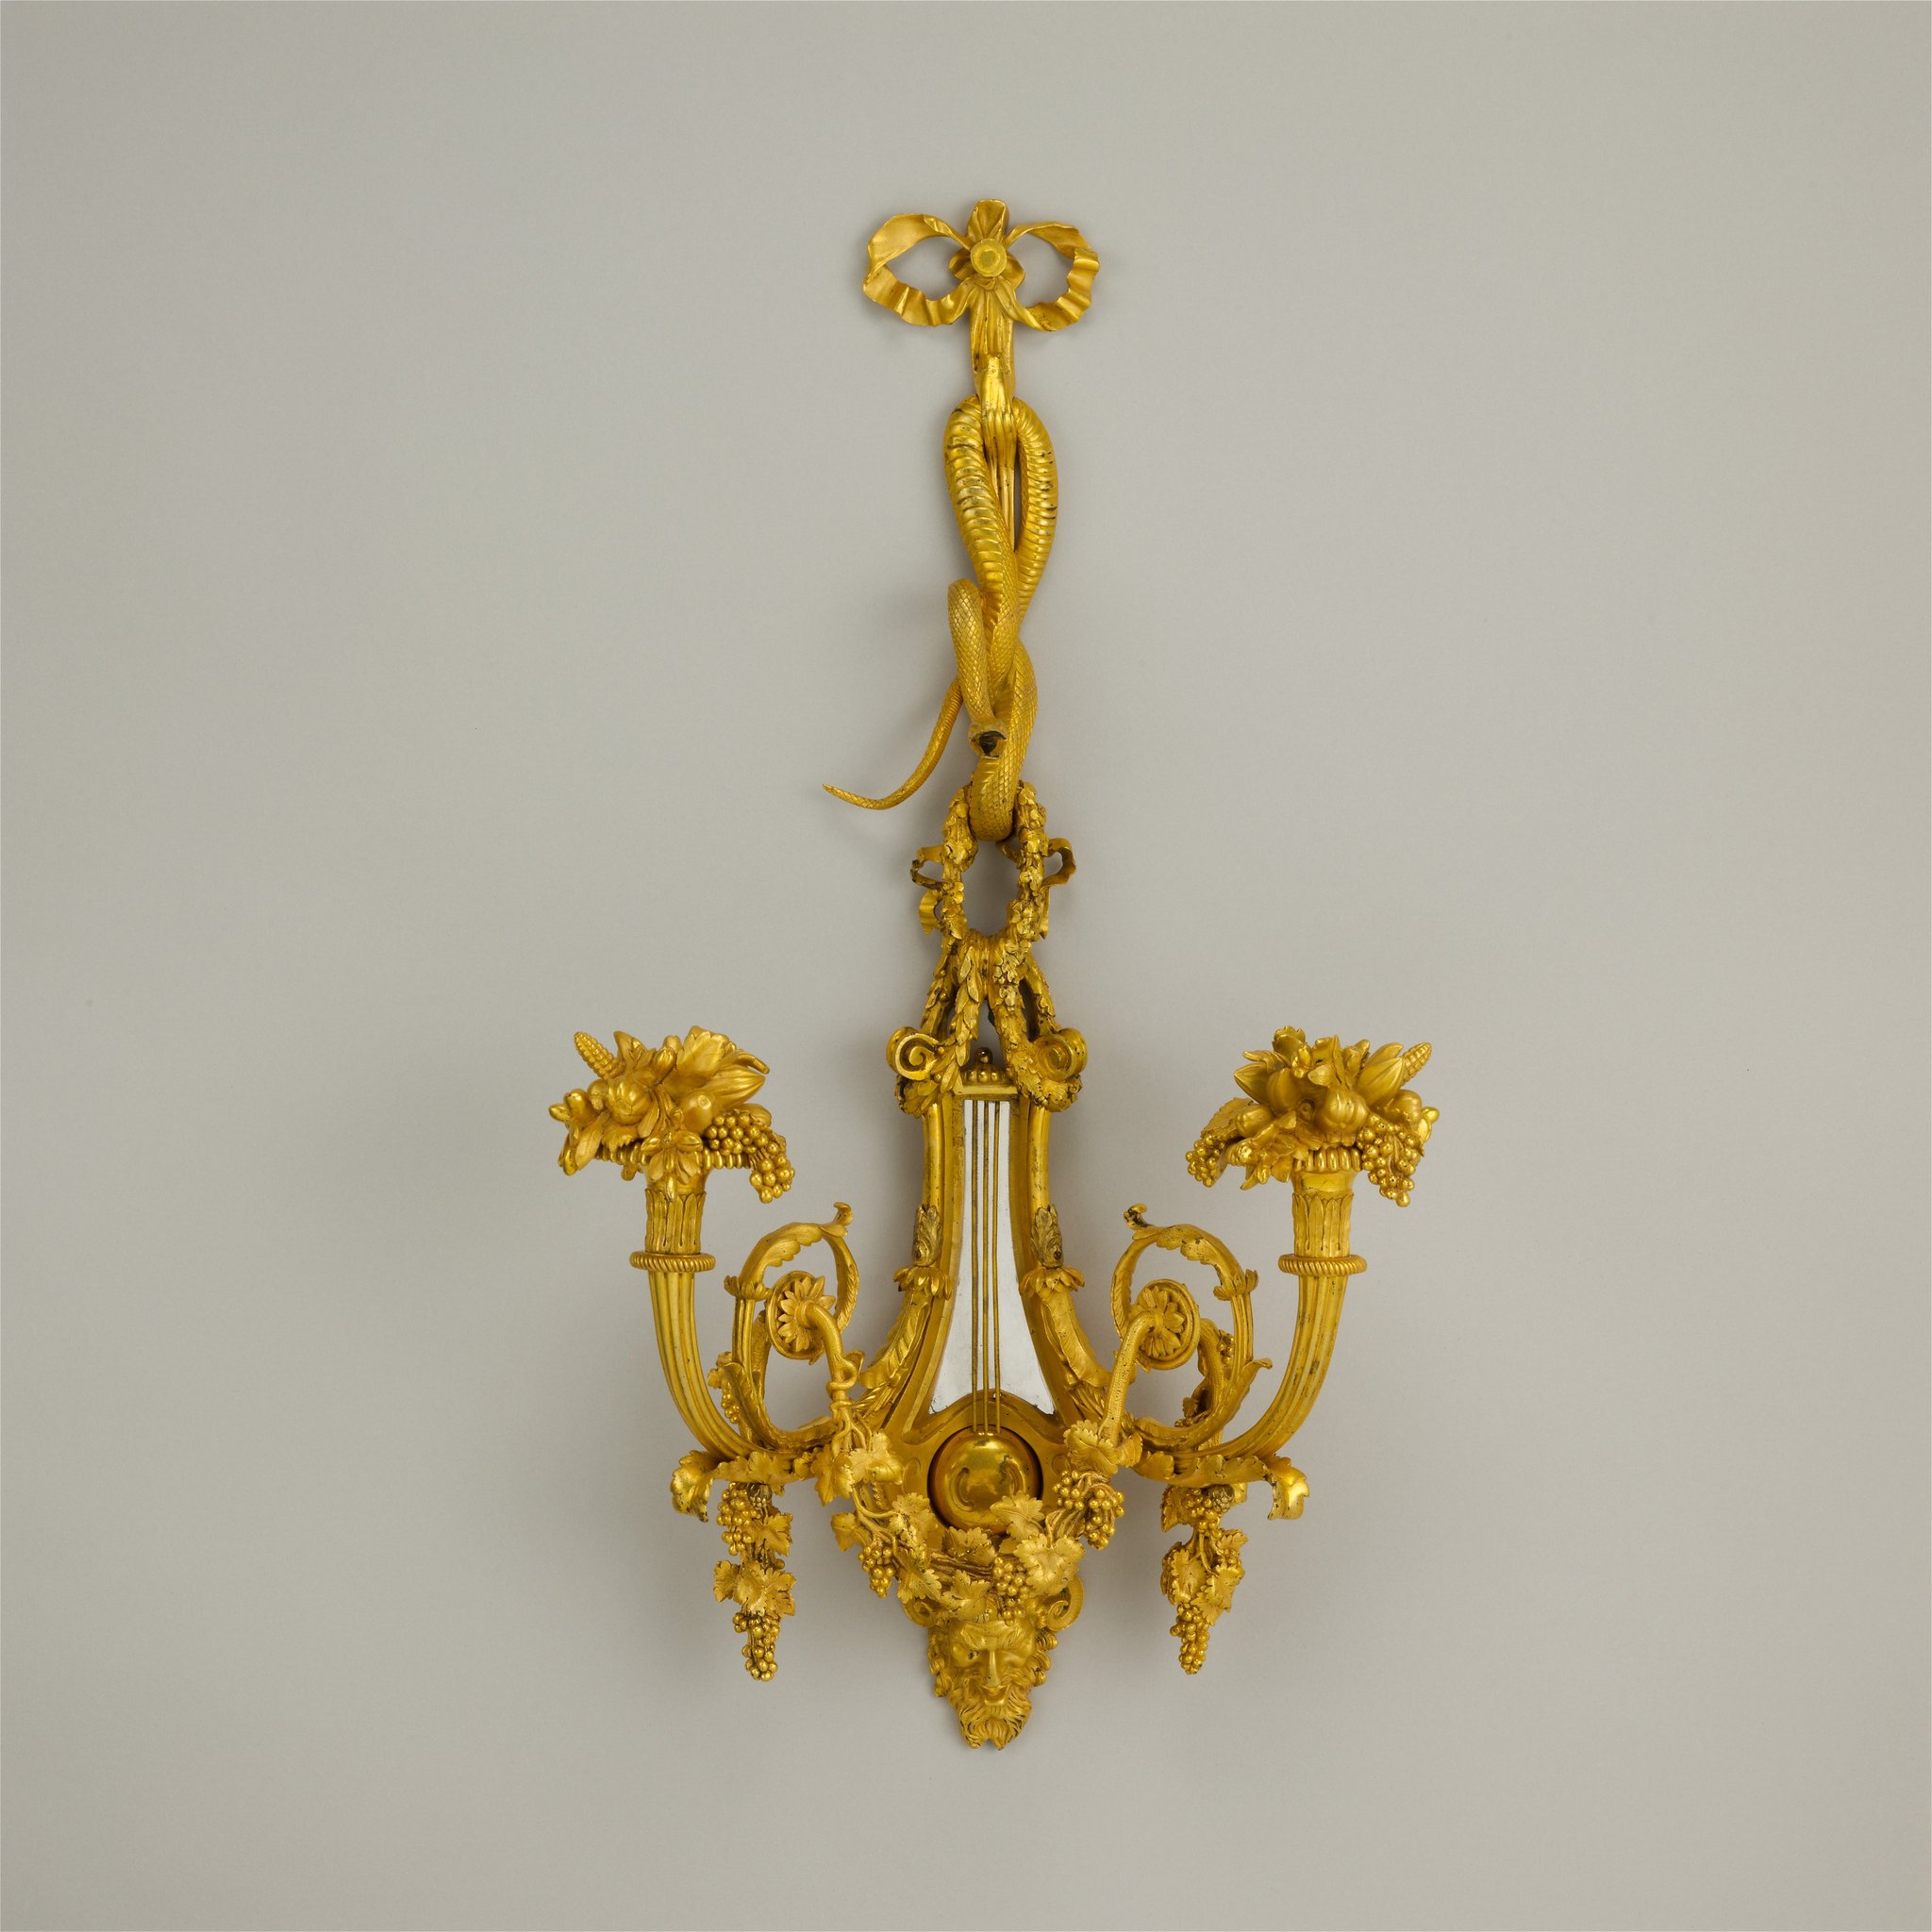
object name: wall bracket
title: Pair of two-light wall brackets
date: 1780-1790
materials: gilt bronze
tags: fruit